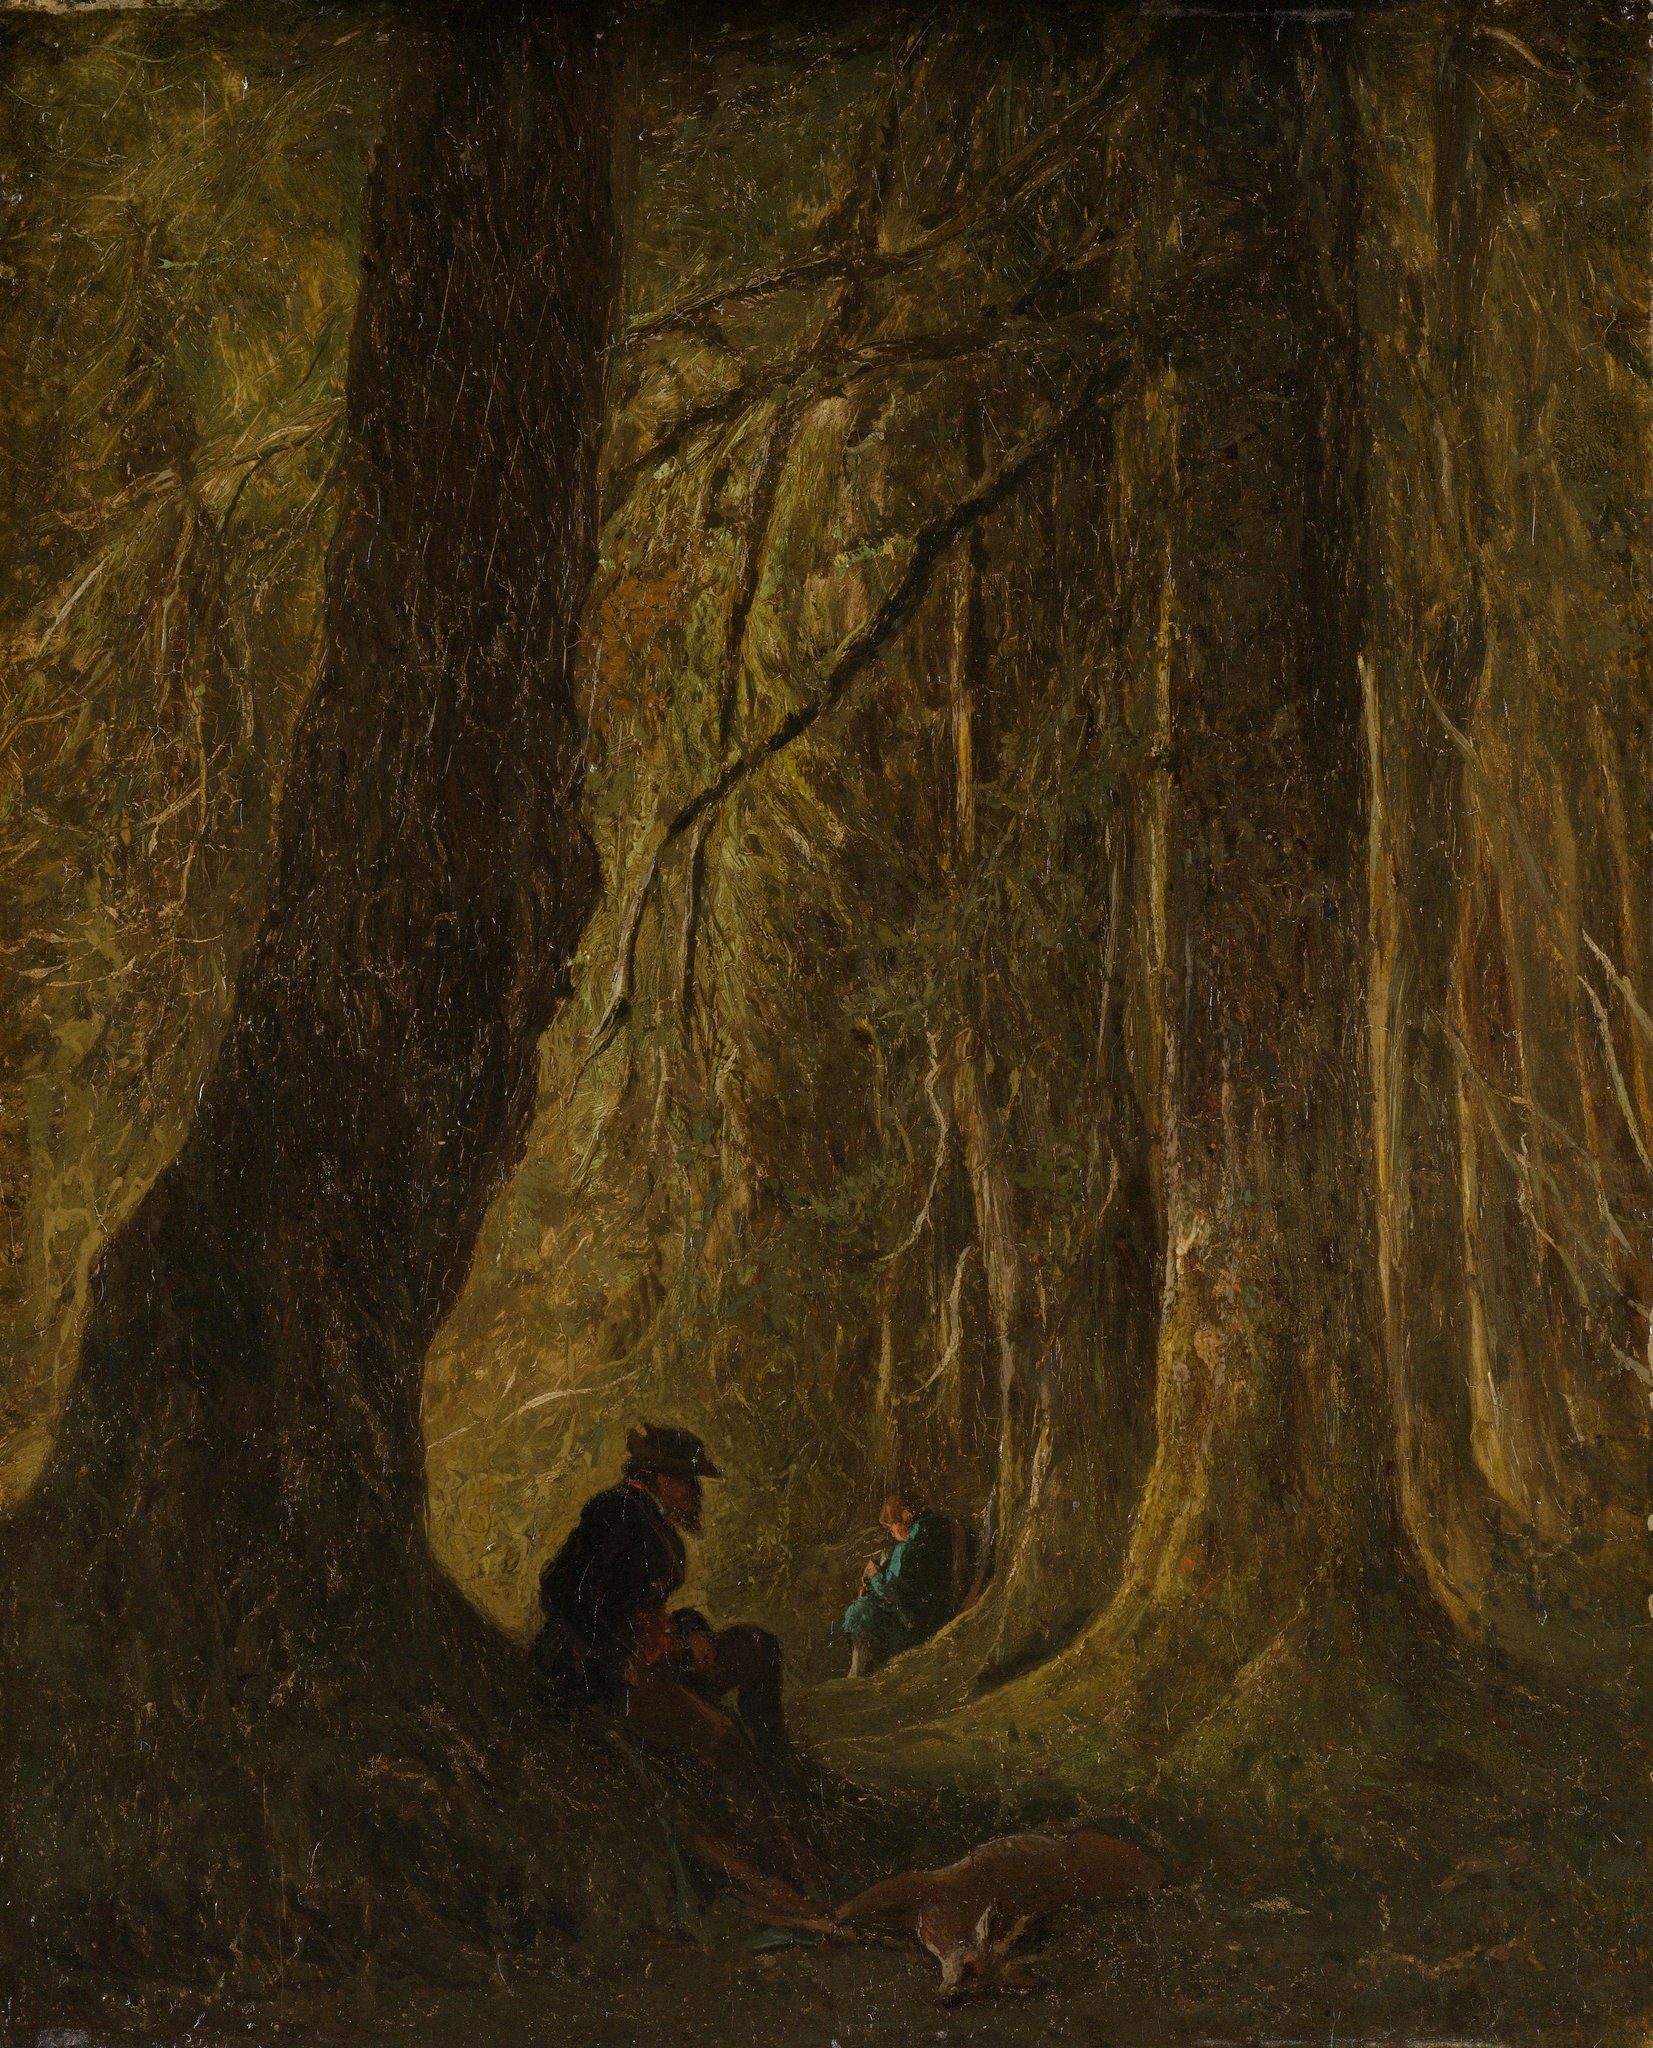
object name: painting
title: Op drijfjacht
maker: johannes tavenraat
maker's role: draughtsman, painter, print maker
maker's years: 1809-1881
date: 1830-1860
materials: oil, panel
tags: hunter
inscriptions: inscription: ‘Mijzelf op een drijfjacht in't Clever Reichswald’, signature: ‘Tavenraat’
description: De kunstenaar Johannes Tavenraat zittend onder hoge bomen tijdens een drijfjacht in het bos de Klever Reichswald. Op de voorgrond ligt wat geschoten wild, iets naar achteren zit een tweede figuur.